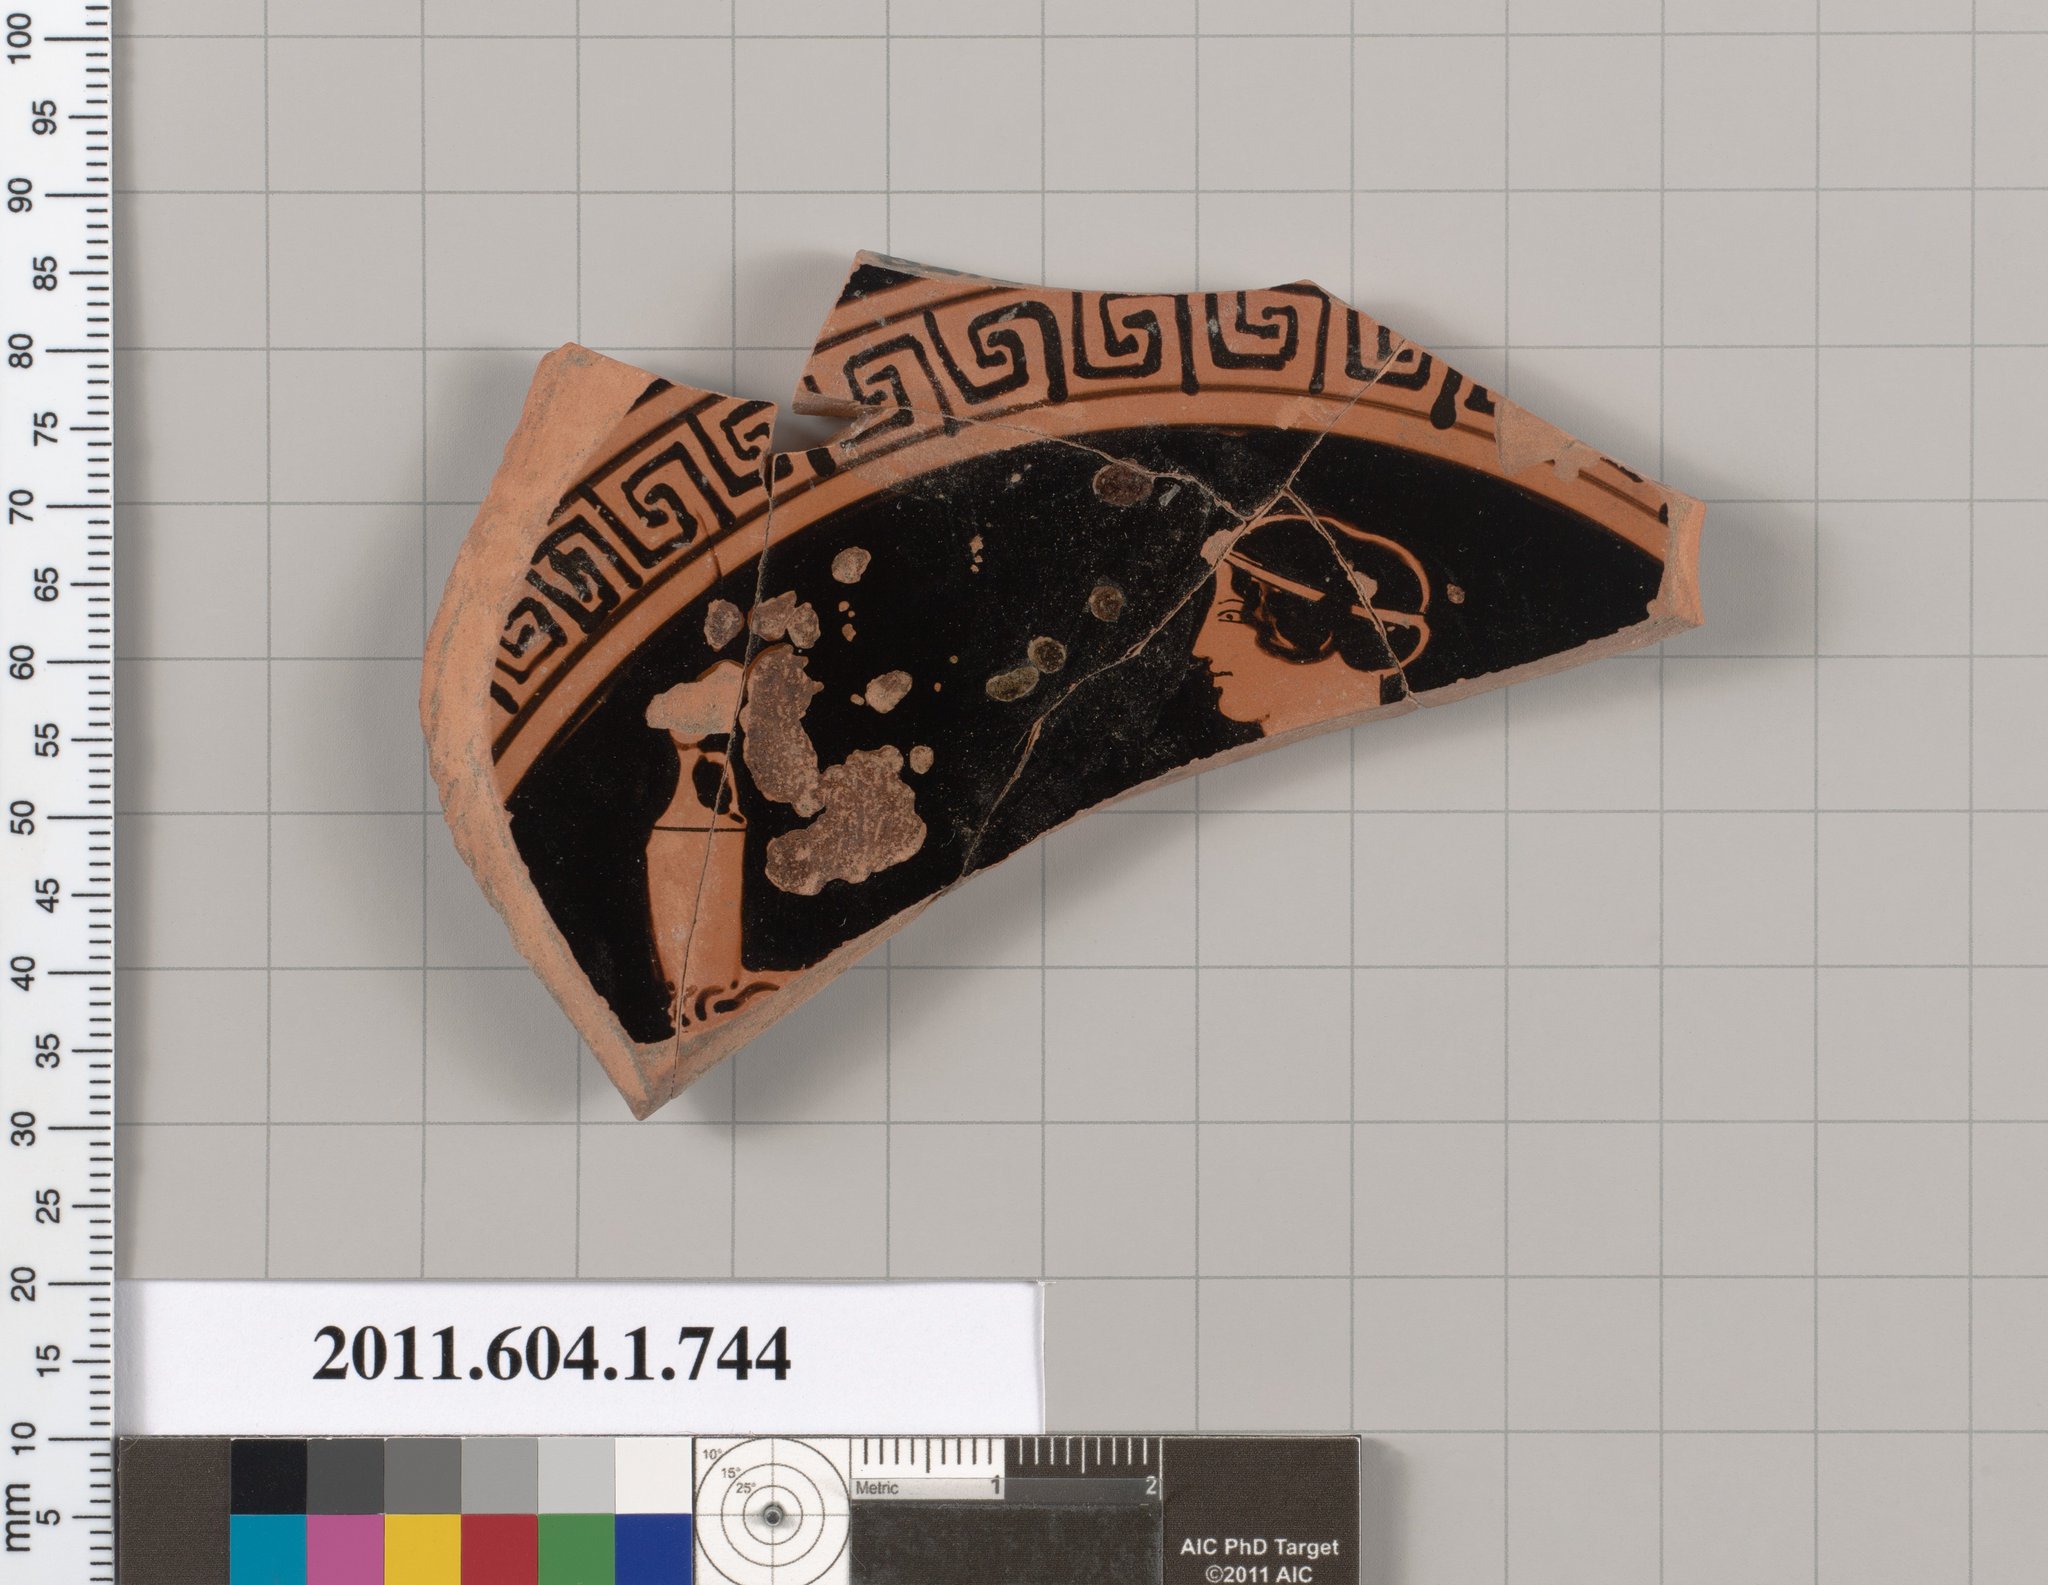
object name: kylix fragment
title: Terracotta fragment of a kylix (drinking cup)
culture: greek, attic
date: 475-451 BCE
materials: terracotta